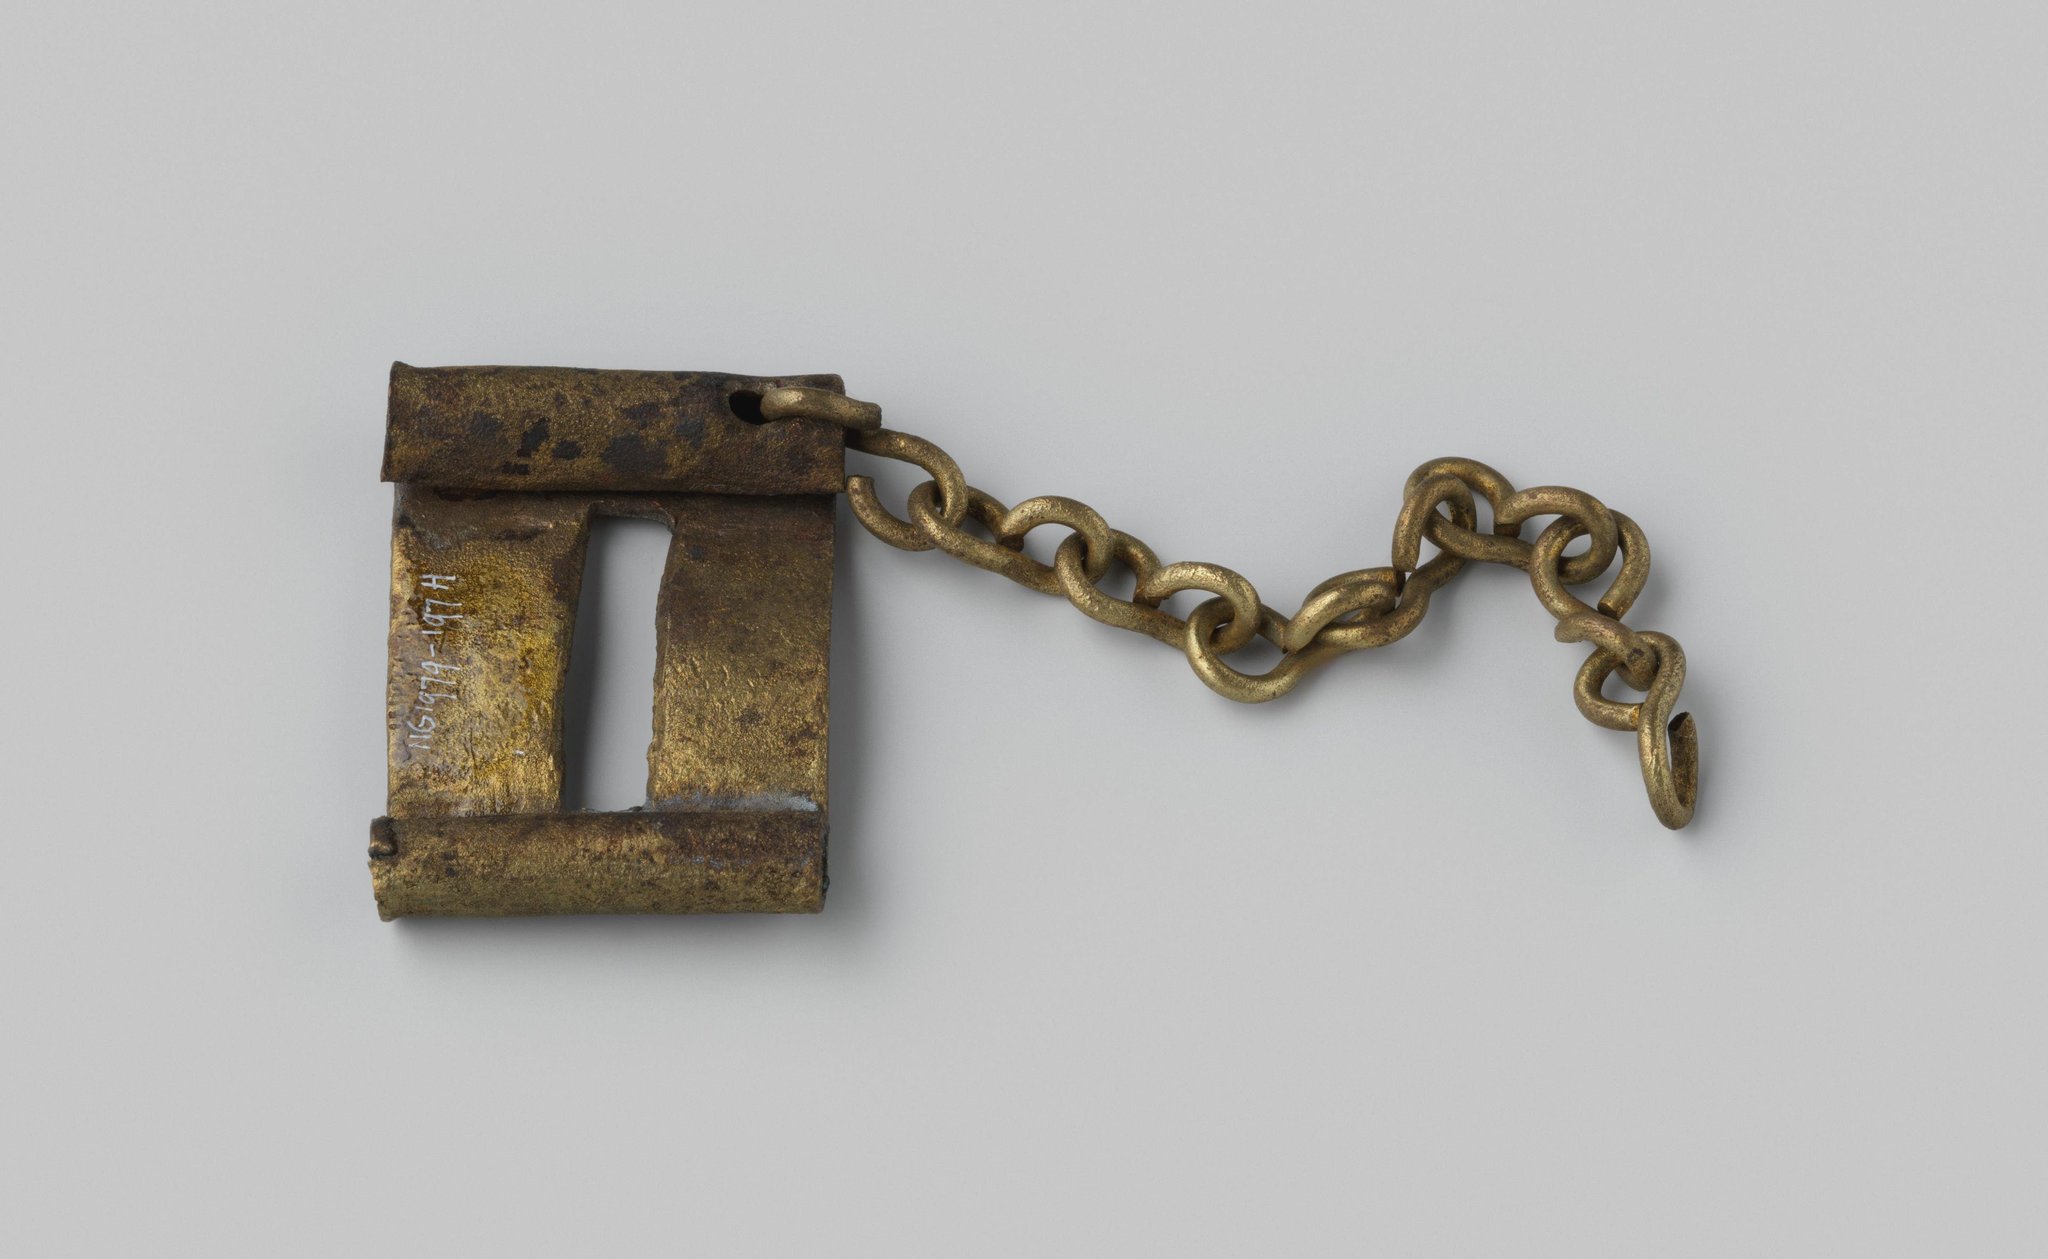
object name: hasp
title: Beugel met ketting uit het wrak van de Oost-Indiëvaarder Hollandia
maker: Anonymous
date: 1700-1743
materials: copper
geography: netherlands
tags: verenigde oostindische compagnie, hollandia (schip), annet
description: Locks, fastenings and accessories, hasp; rectangular plate, slightly curved, both short sides with rolled rims, oblong slot in centre, chain attached through hole in corner: sim. chain NG 1980-27H3151.